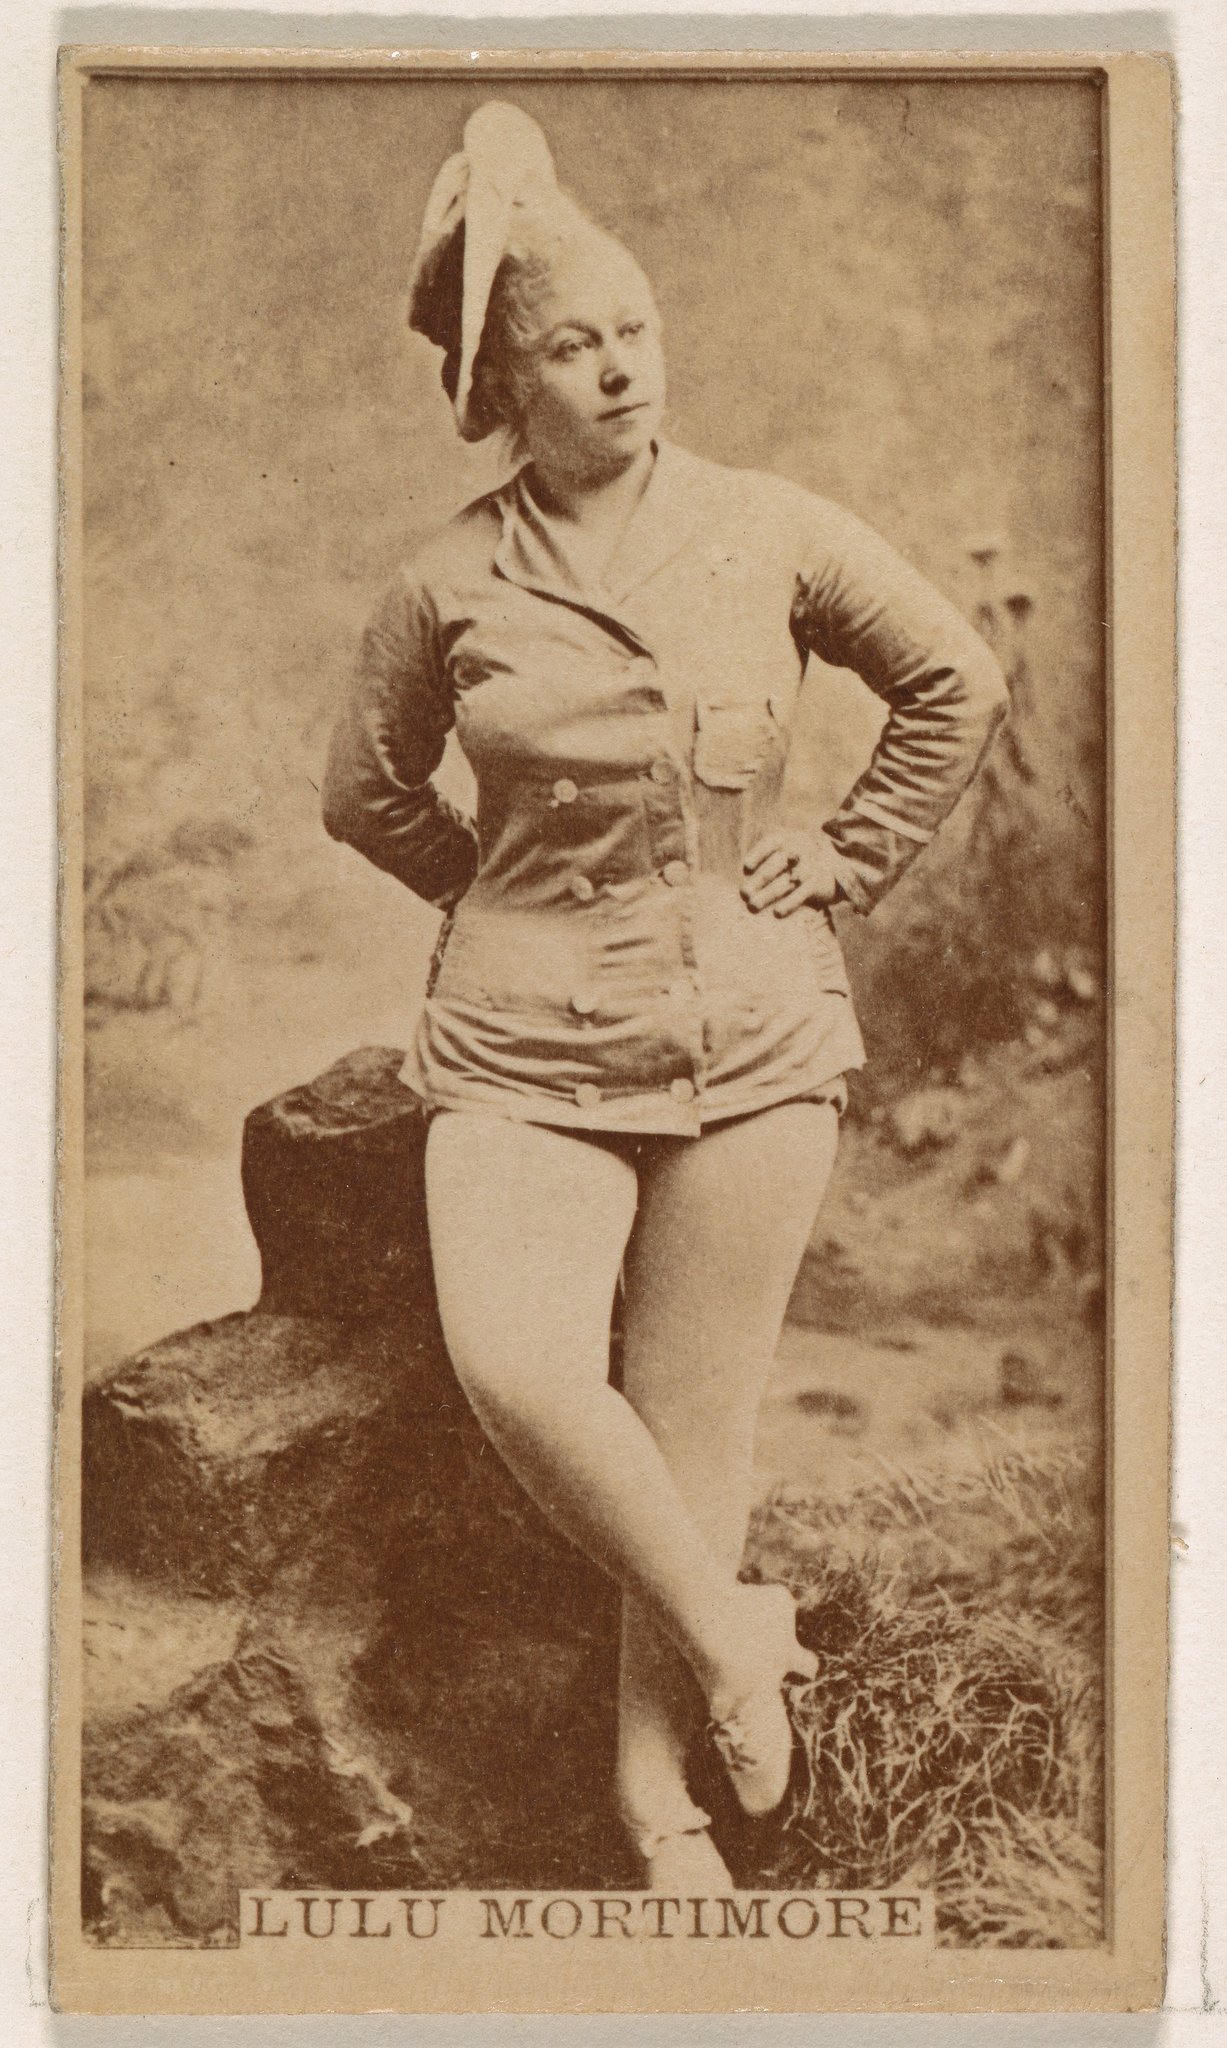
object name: photograph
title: Lulu Mortimore, from the Actresses series (N245) issued by Kinney Brothers to promote Sweet Caporal Cigarettes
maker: kinney brothers tobacco company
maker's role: publisher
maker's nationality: american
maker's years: 1869-2011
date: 1890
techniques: albumen silver print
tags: portraits,women,actresses